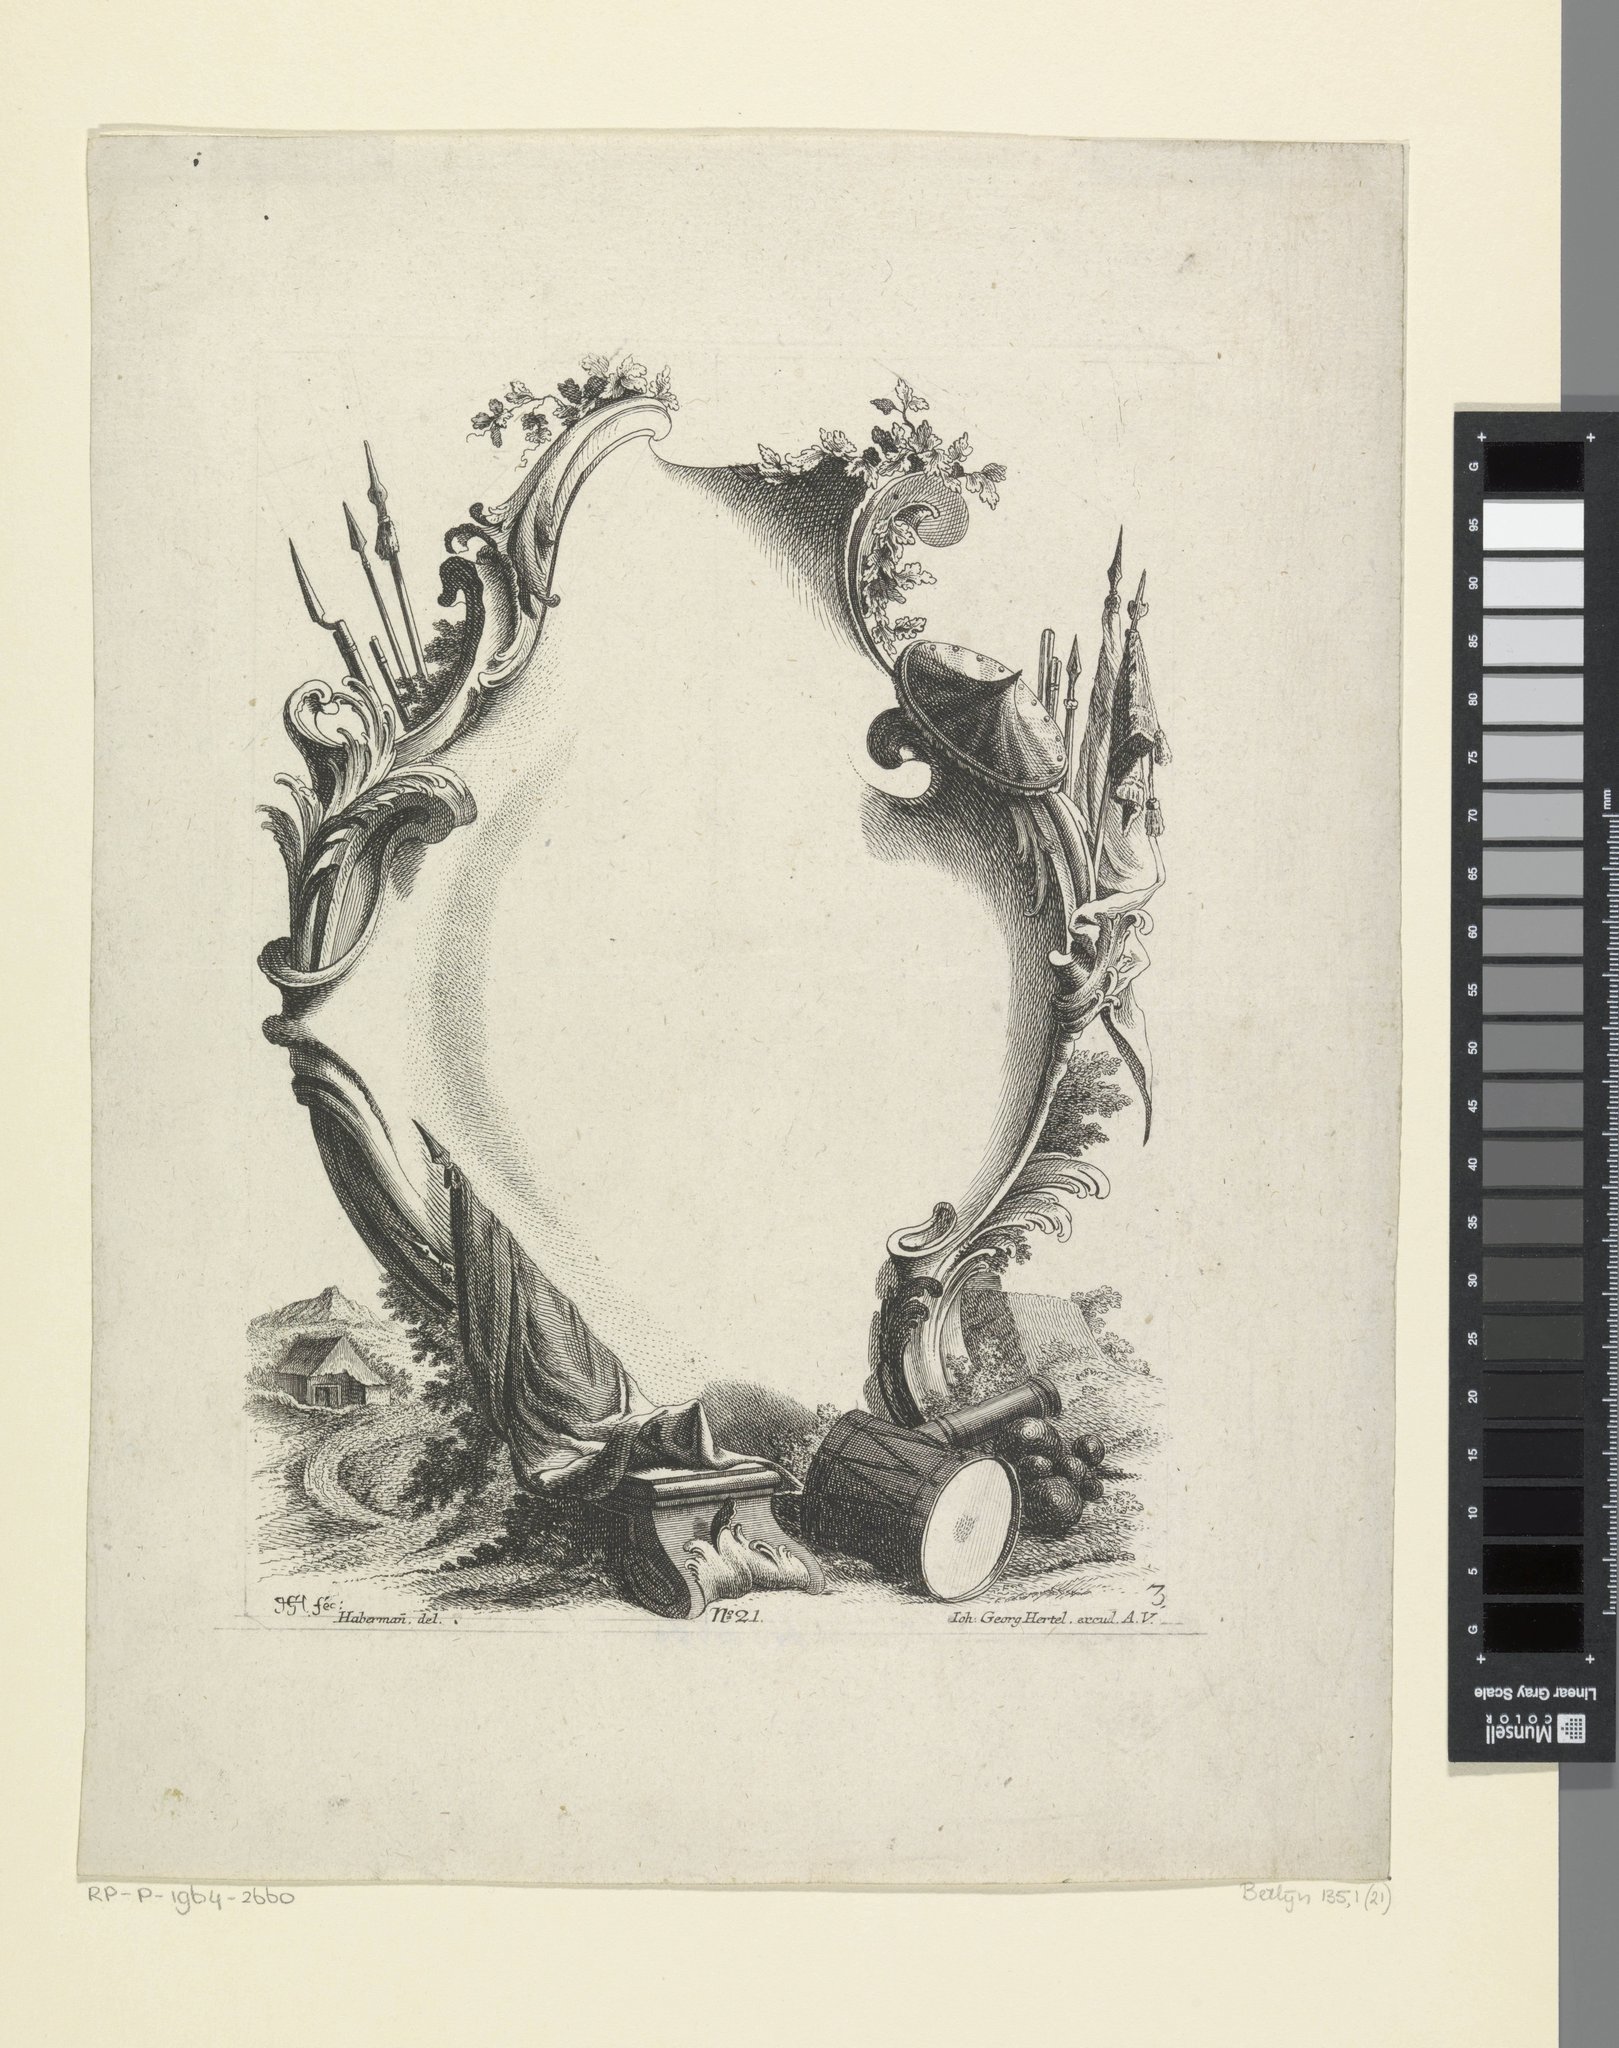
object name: ornament print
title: Cartouche met militaire objecten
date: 1731-1775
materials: paper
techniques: etching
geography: augsburg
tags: ornament ~ cartouche, (military) equipment and supply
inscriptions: collector's mark: Lugt 2760, collector's mark: Lugt 2228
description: Rocaille cartouche met objecten te maken met oorlog en strijd zoals diverse lansen, speren, vlaggen, kanon en kogels en een trom. Uitgeversnummer 21.